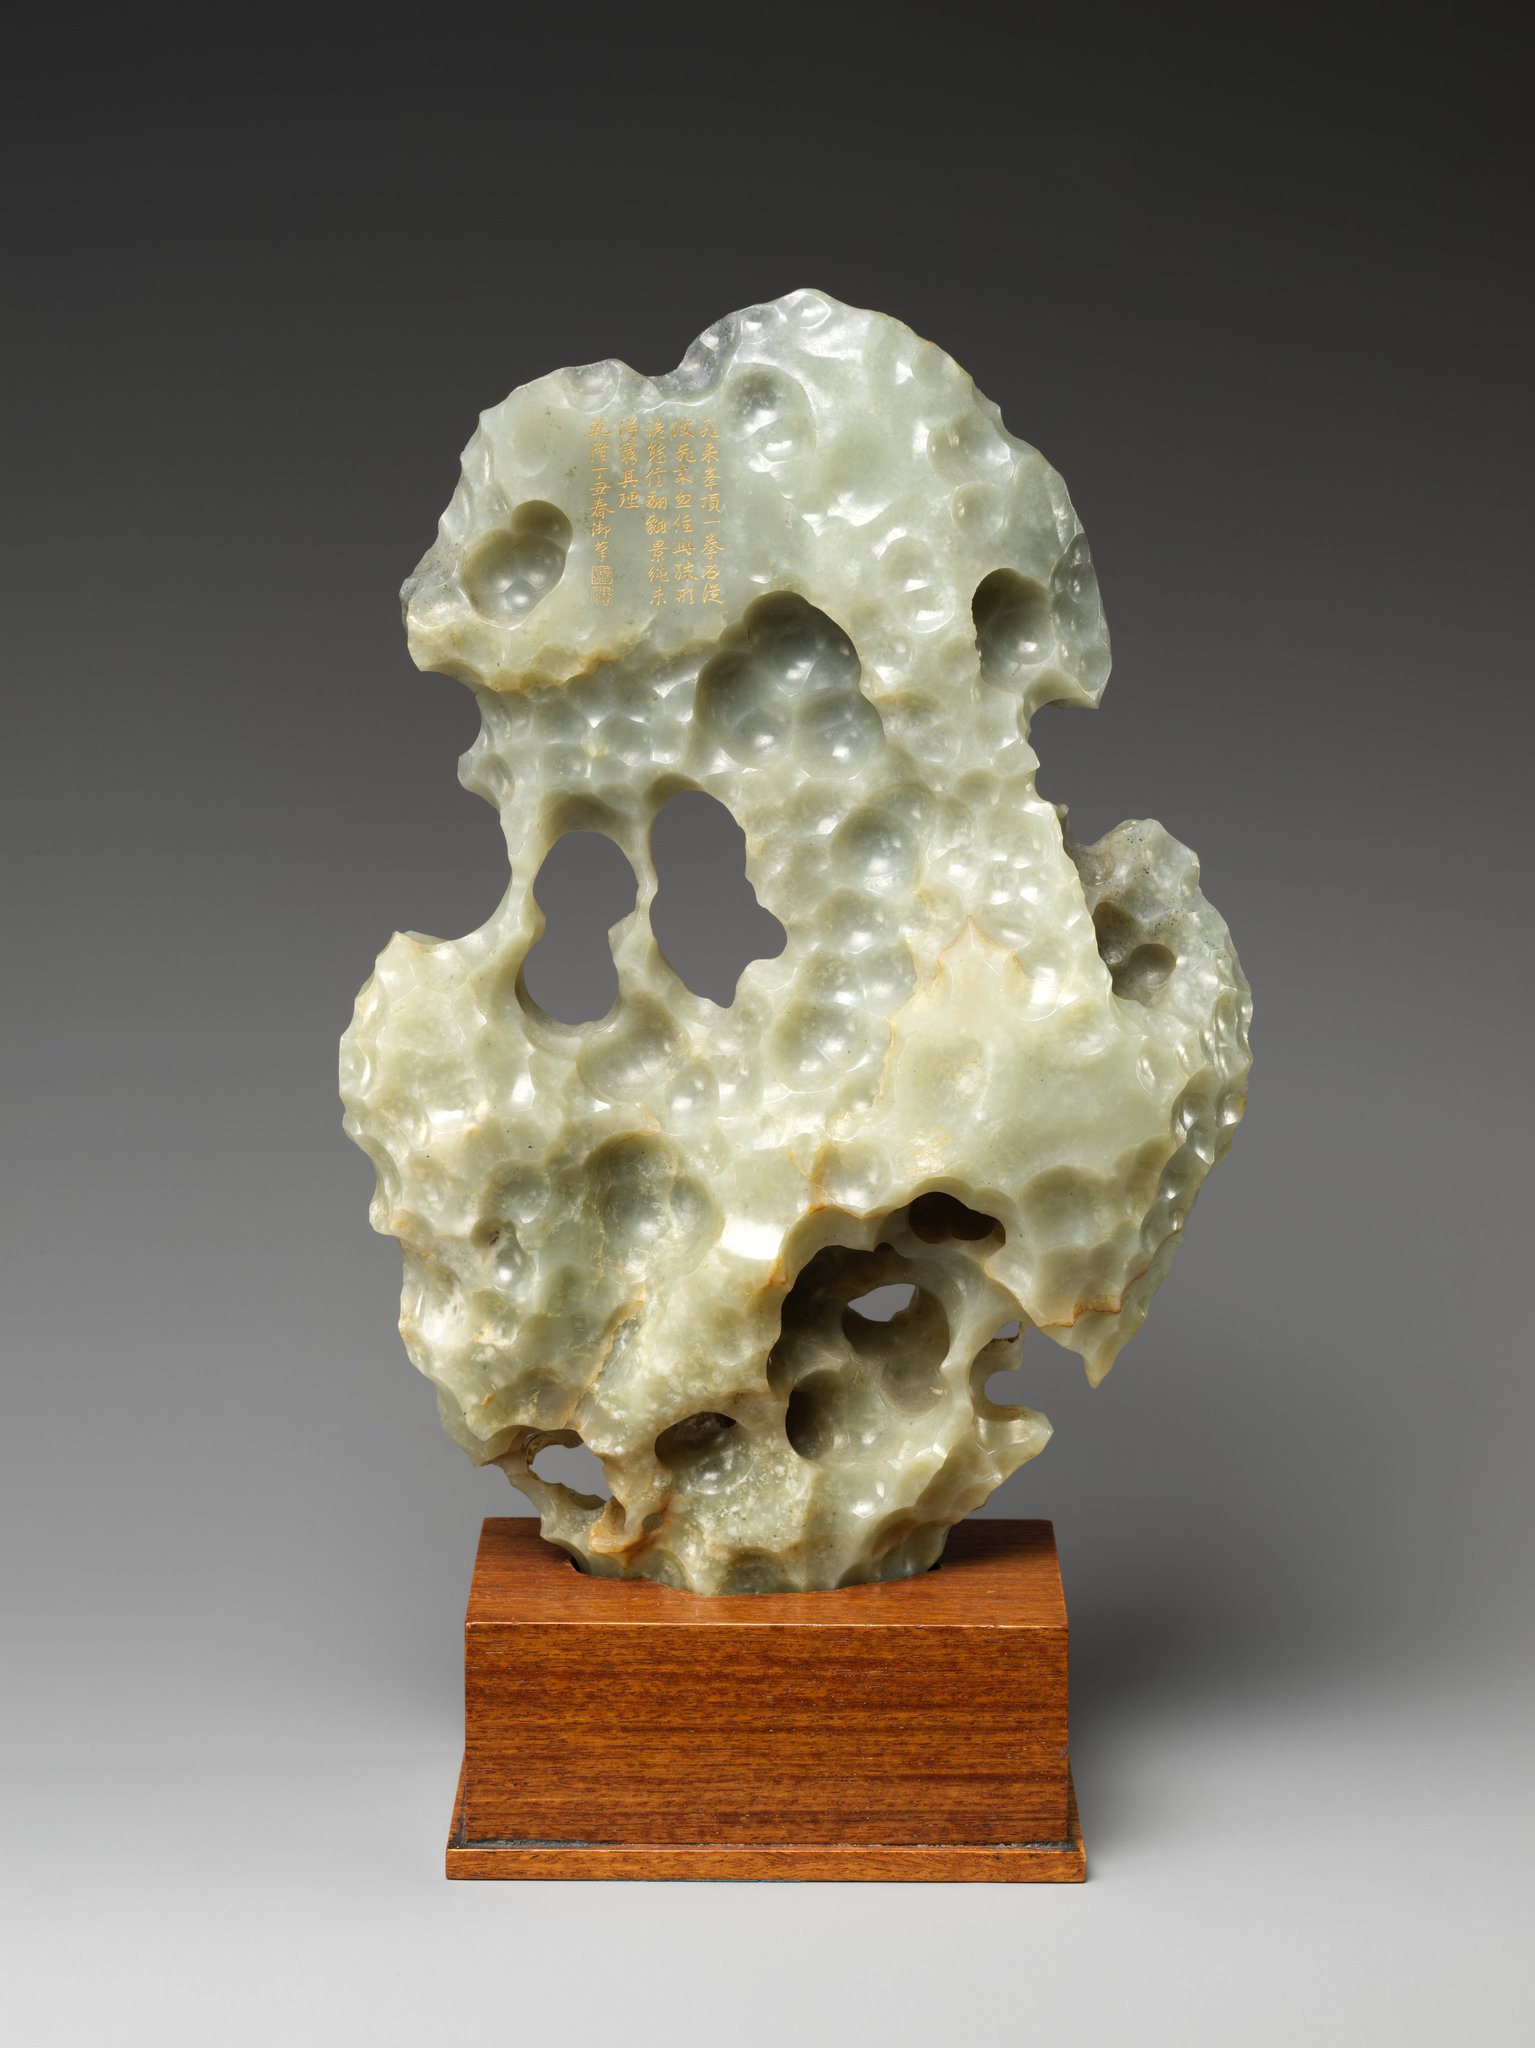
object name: rock ornament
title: Rock-form ornament with poem composed by the Qianlong Emperor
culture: chinese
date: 1701-1800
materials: jade